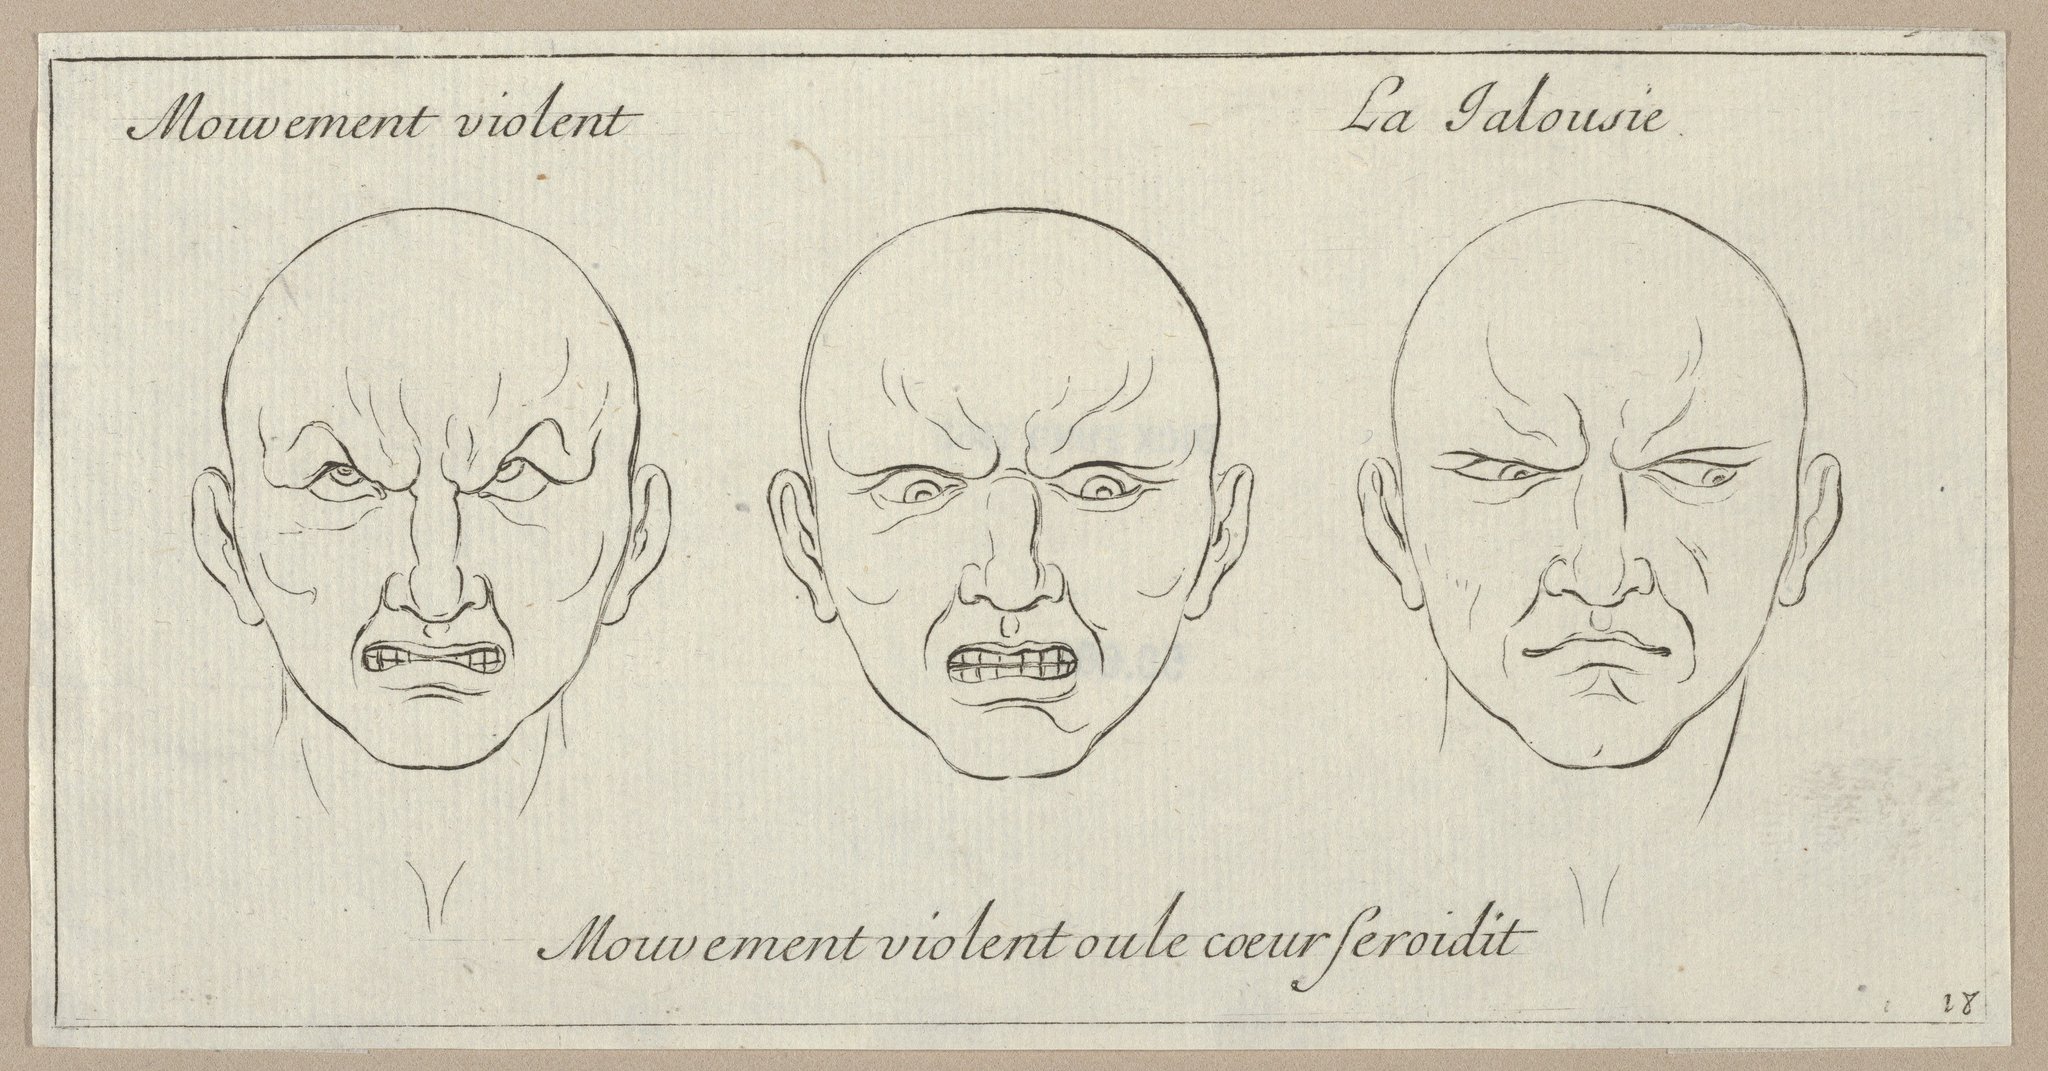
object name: print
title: Mouvement Violent, Mouvement violent ou le coeur seroidit, La Jalousie, from "Caractères des passions, gravés sur les desseins de l'illustre Monsieur le Brun"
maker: sébastien le clerc, le jeune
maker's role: etcher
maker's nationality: french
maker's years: 1676-1763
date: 1695-1720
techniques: etching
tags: heads,anger,men